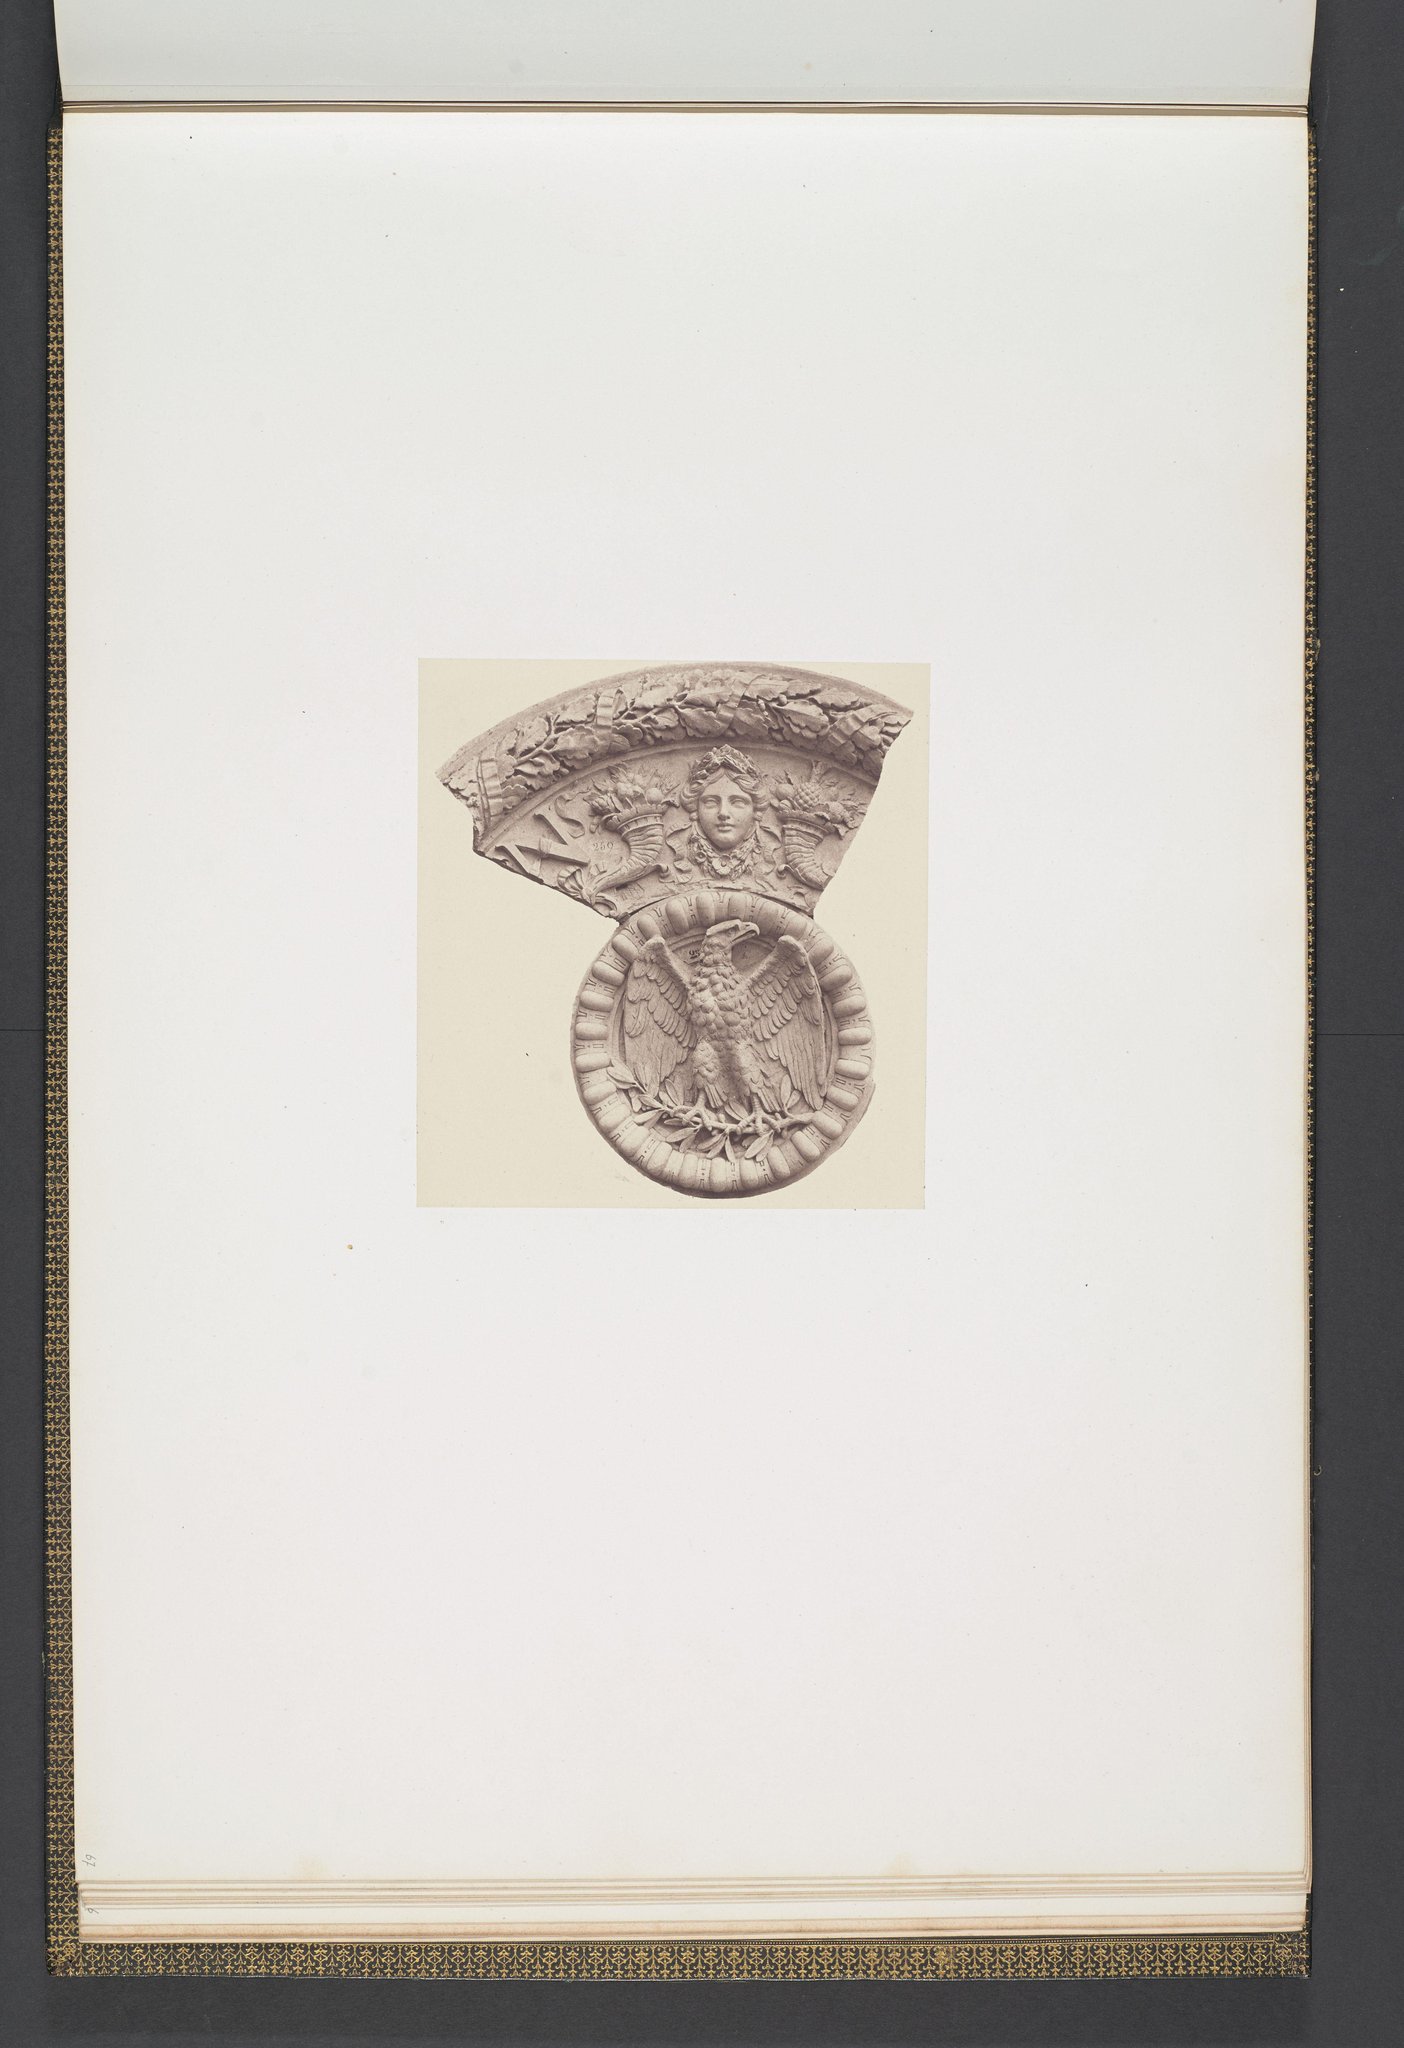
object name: photograph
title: Gipsmodellen voor een gewelfversiering van het Palais du Louvre door Flandrin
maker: édouard denis baldus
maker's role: fotograaf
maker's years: 1813-1889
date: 1855-1857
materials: paper, photographic support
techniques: salted paper print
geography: paris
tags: permanent exhibition, museum, ornamenting, decorating ~ applied arts, paris, tuileries palace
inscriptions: number: ‘259’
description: Onderdeel van Réunion des Tuileries au Louvre 1852-1857, album 3.